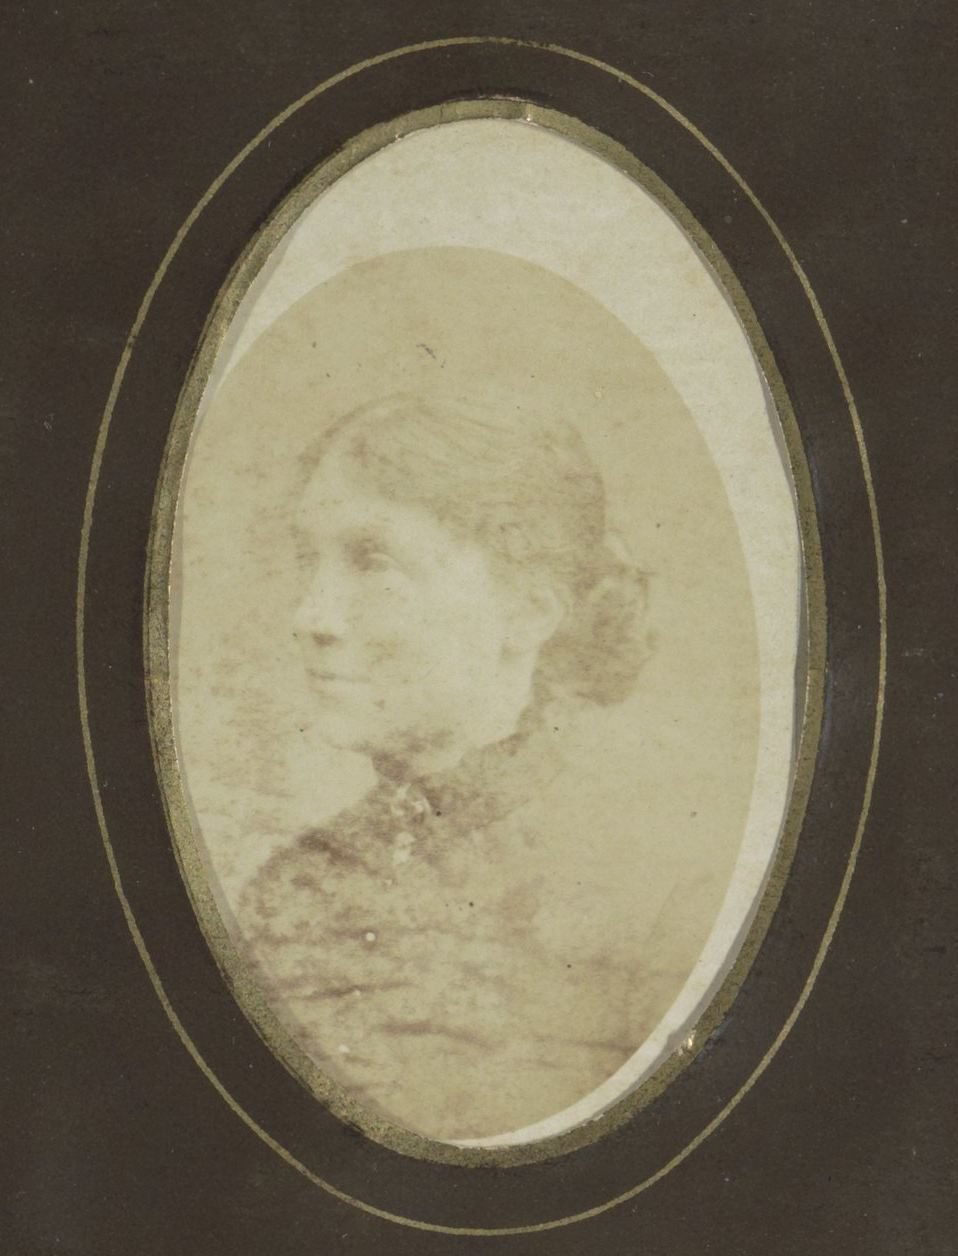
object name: carte de visite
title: Portret van een vrouw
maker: carel frederik cordes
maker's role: fotograaf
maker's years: 1851-1927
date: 1880-1910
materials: cardboard, paper, photographic support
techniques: albumen print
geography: den bosch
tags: adult woman, historical persons not known by name - bb - woman, den bosch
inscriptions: address: ‘parade 's Bosch’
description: Onderdeel van Fotoalbum van de families Matthes, Doorman en Van Thiel.